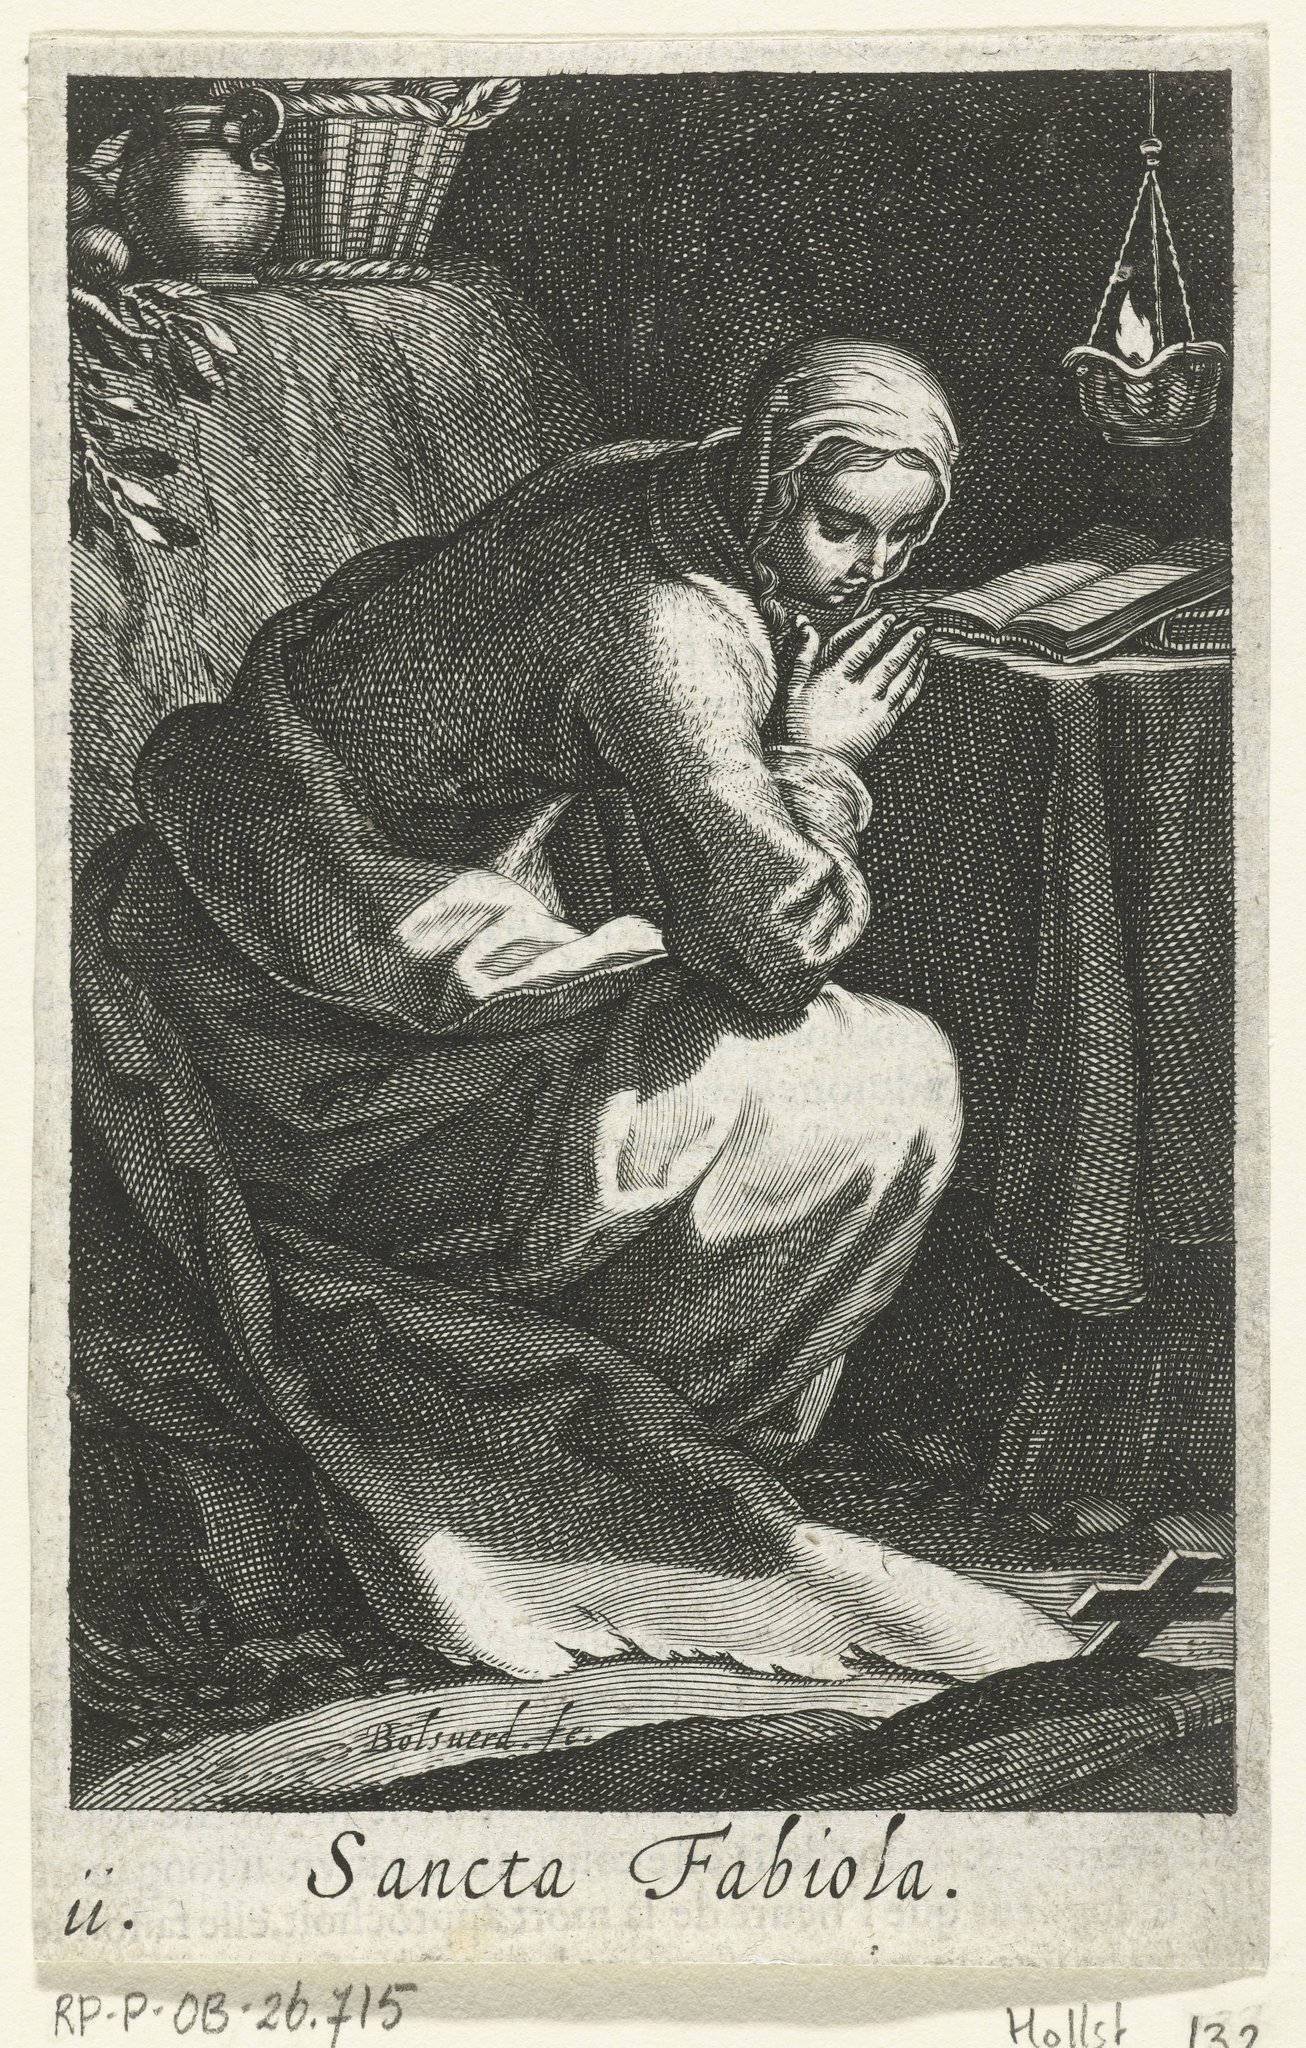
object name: book illustration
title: Heilige Fabiola van Rome als kluizenares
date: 1590-1612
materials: paper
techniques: engraving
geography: antwerp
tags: anchorite, hermit, female saints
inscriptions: collector's mark: Lugt 2228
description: Prent uit: Sacra Eremus Ascetriarum, Hendrik Aertssen, Antwerpen 1619. Prent uit de serie van vijfentwintig kluizenaressen in deze uitgave. In 1612 verscheen de ongebonden editie maar op basis van de gewijzigde opschriften en samenstelling van de serie kluizenaars wordt aangenomen dat de prenten van de uitgave 1619 ook in 1612 of iets daarvoor gedrukt werden. De serie kluizenaressen bleef vrijwel ongewijzigd in de ongebonden uitgave van 1612, dit compliceert de datering van de losse bladen in de collectie van het RMA, zie Roethlisberger 1993, p. 171-175. Door de aanwezigheid van Franse tekst op het verso kunnen we vaststellen dat dit blad afkomstig is uit de Antwerpse uitgave van 1619.